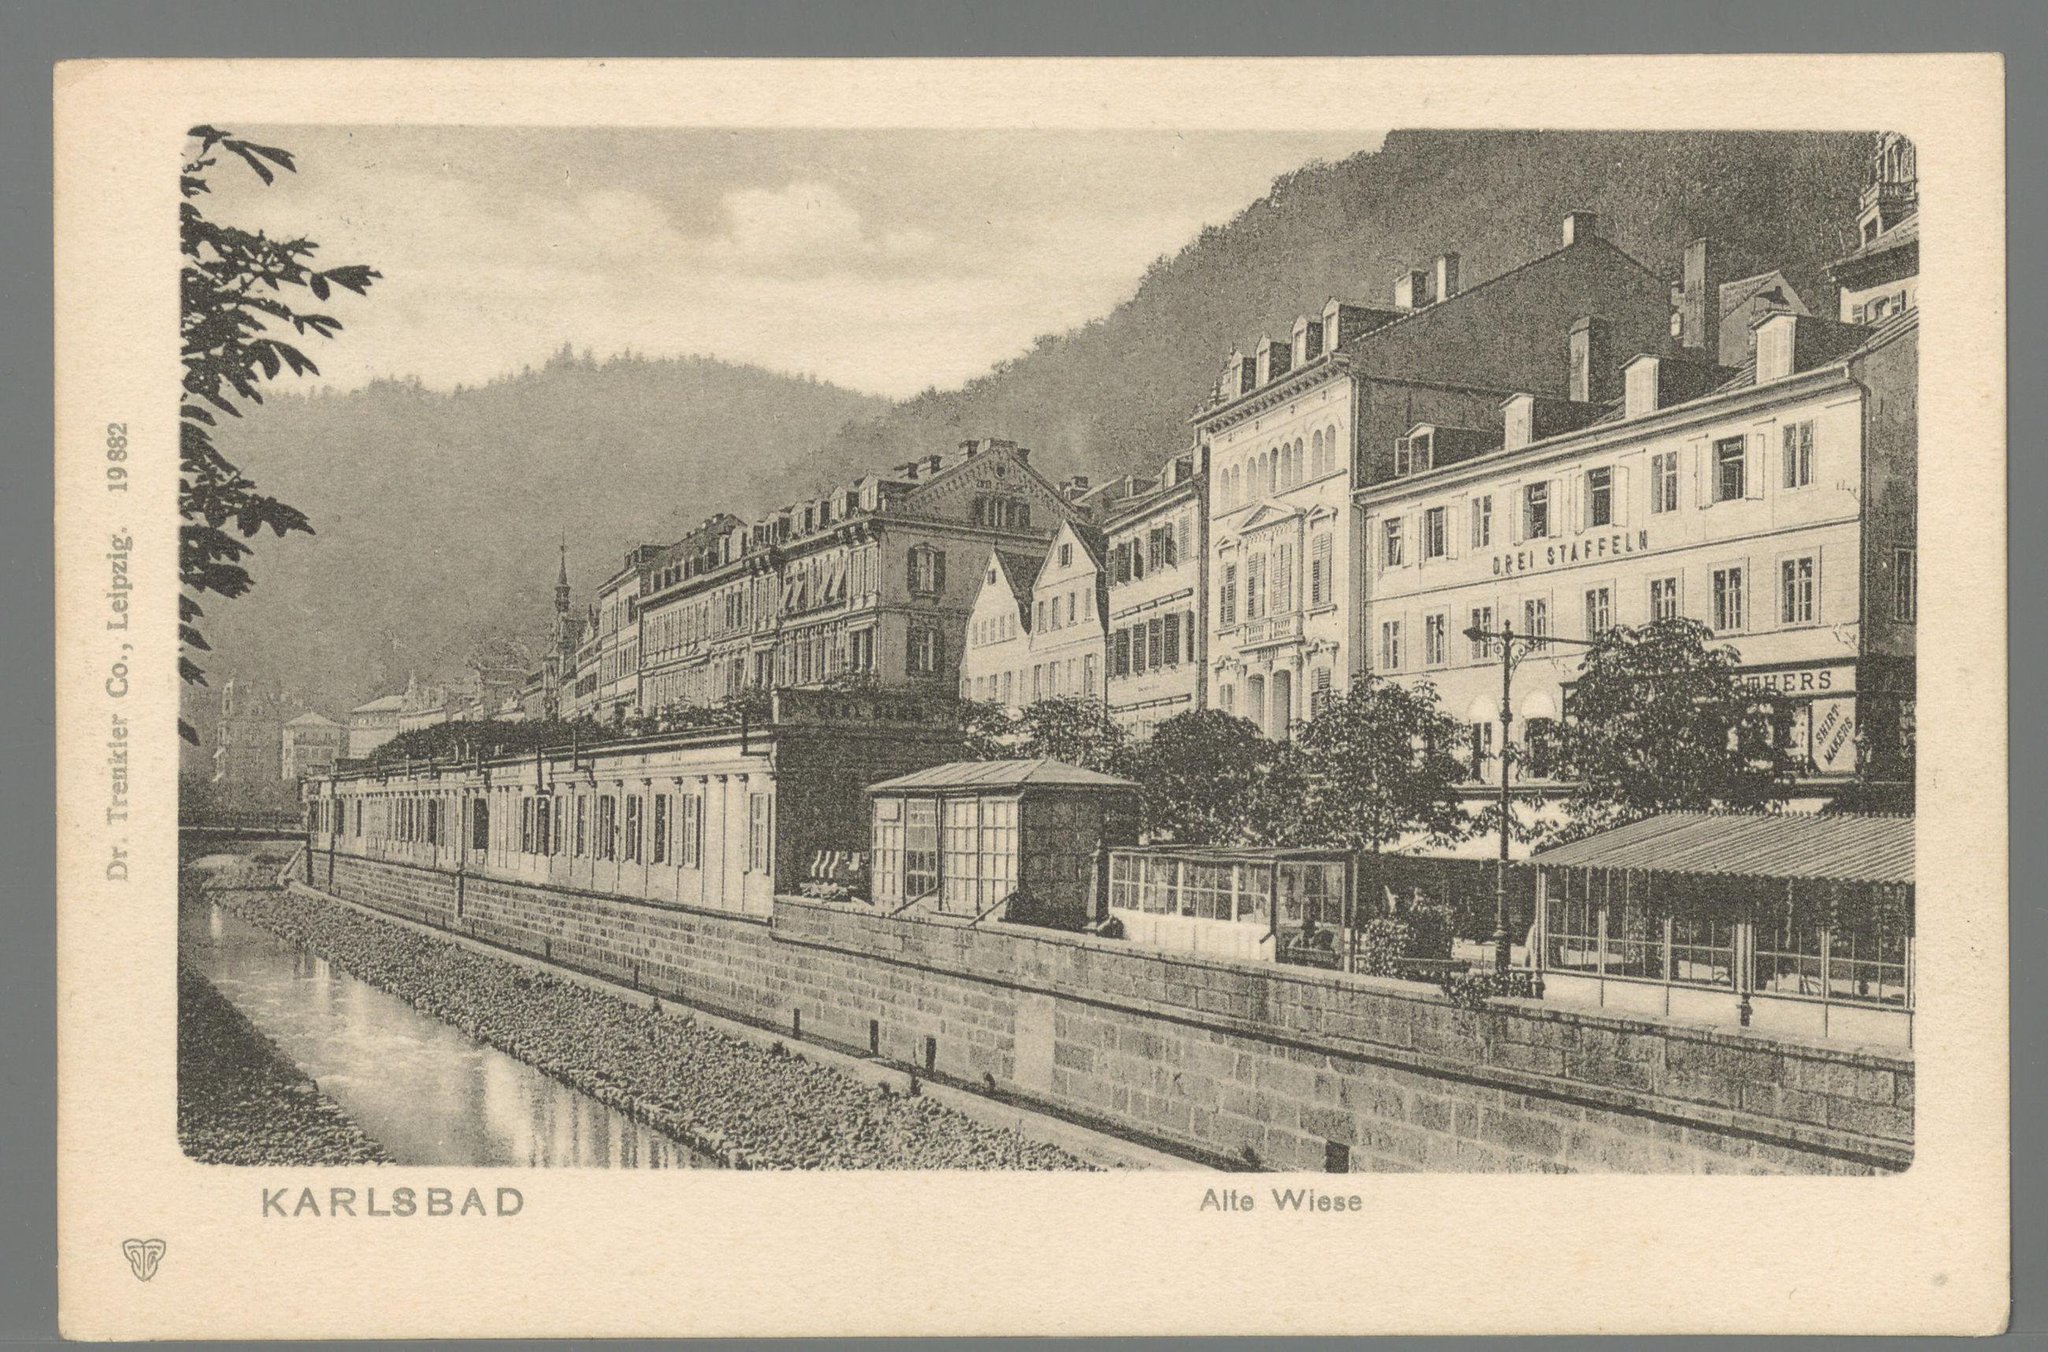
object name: photomechanical print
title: Karlsbad. Alte Wiese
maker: Anonymous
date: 1894-1903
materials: cardboard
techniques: photograph, writing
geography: karlovy vary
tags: street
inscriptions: poststempel, verso, gestempeld